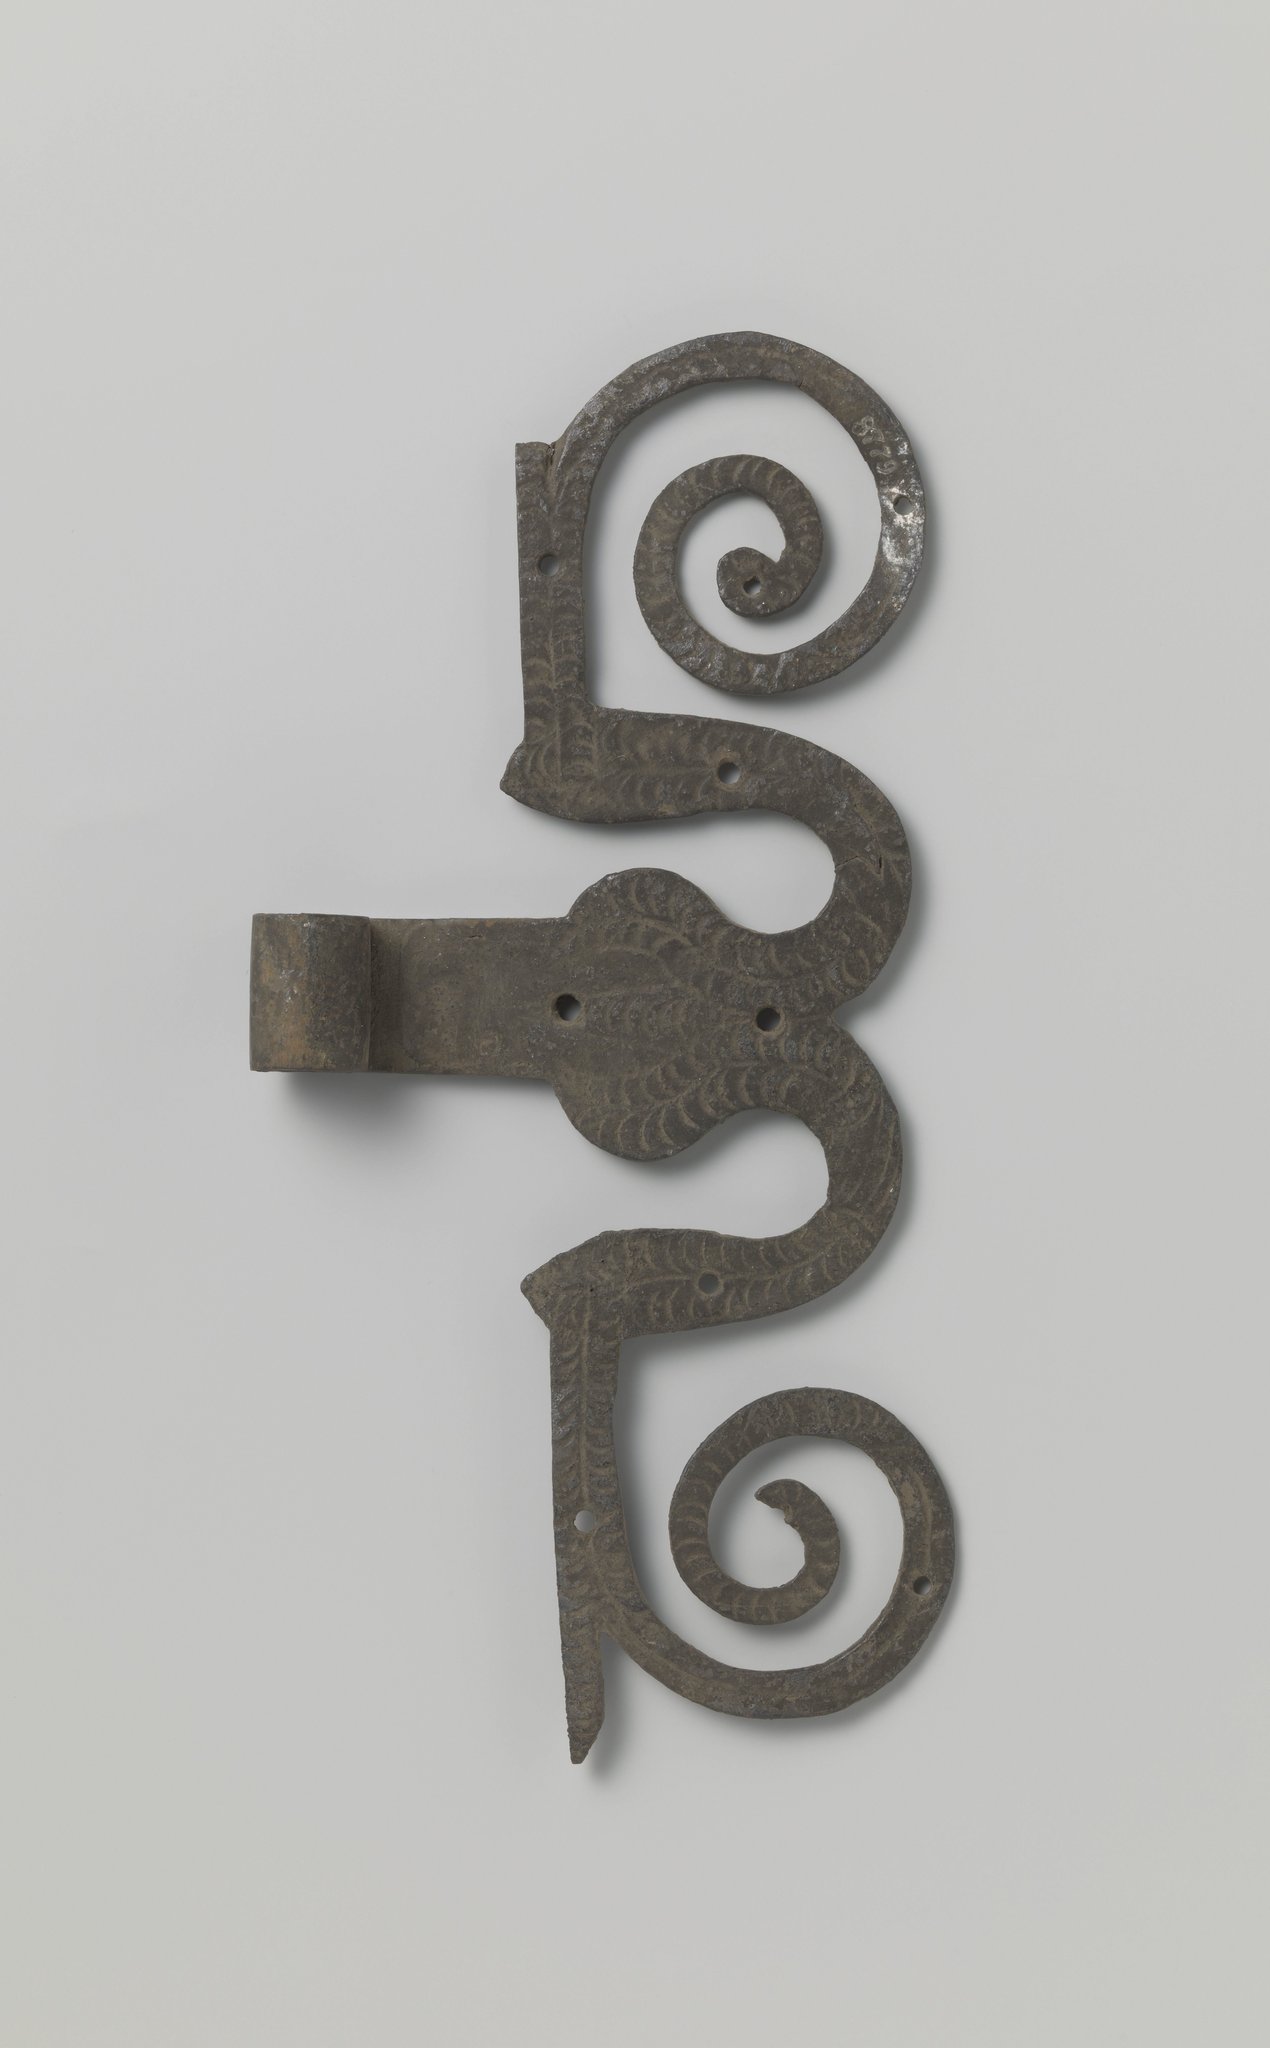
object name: deurhengsel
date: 1400-1950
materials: iron